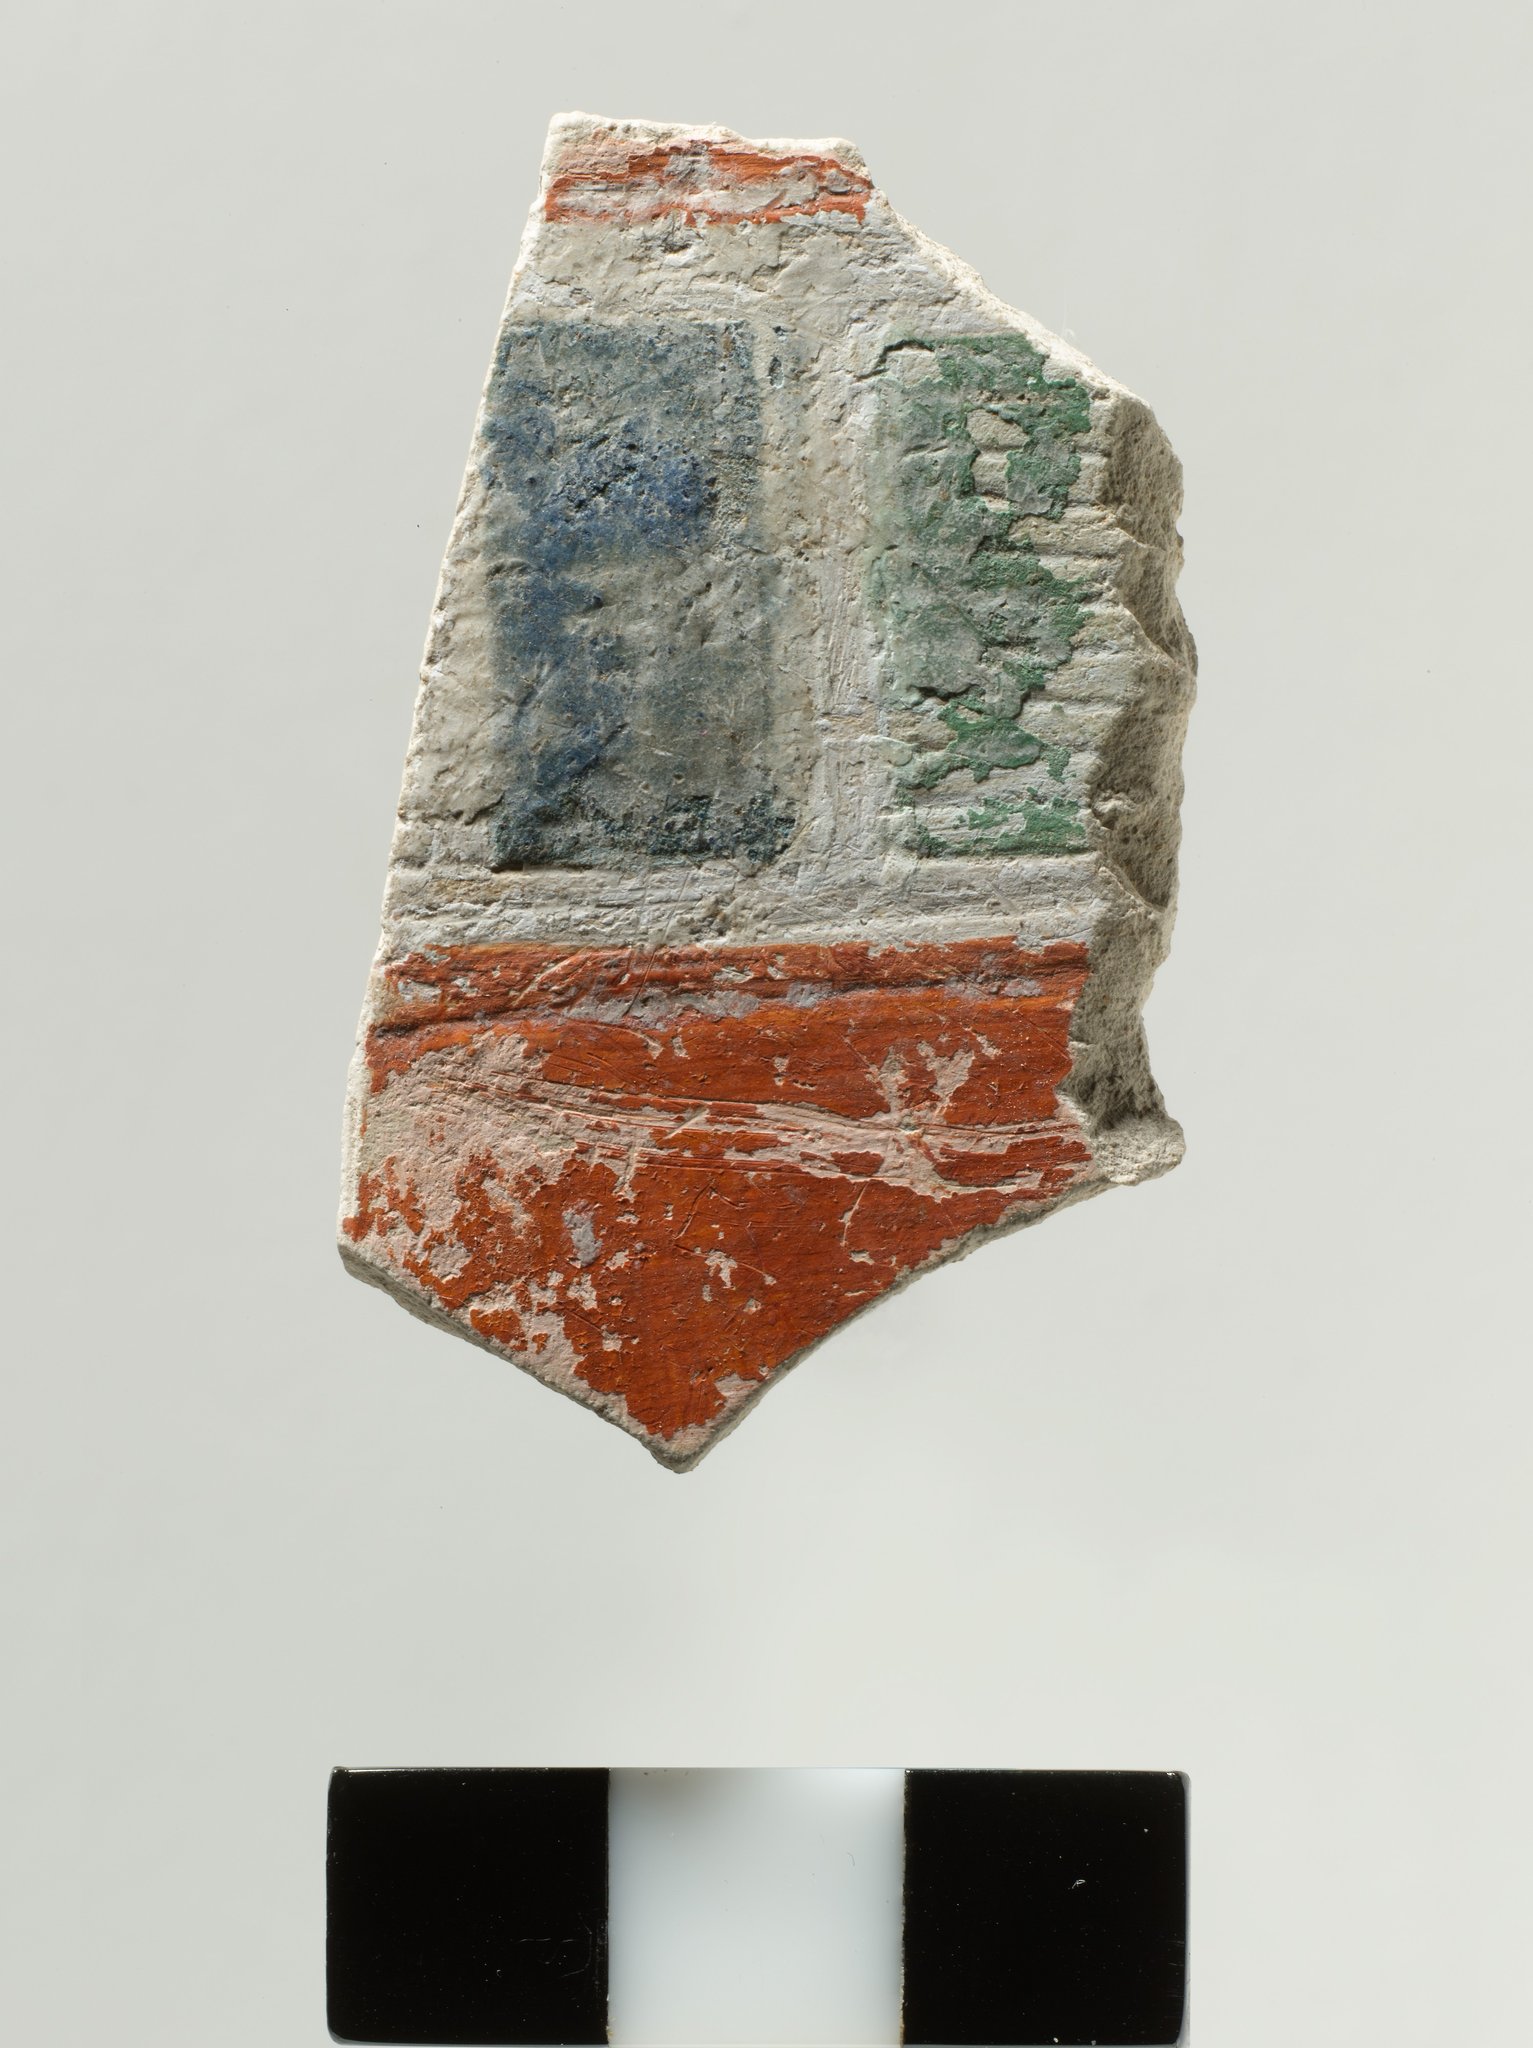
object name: relief fragment, tomb of meketre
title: Reliefs from the tomb of Meketre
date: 1981-1975 BCE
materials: limestone, paint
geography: egypt